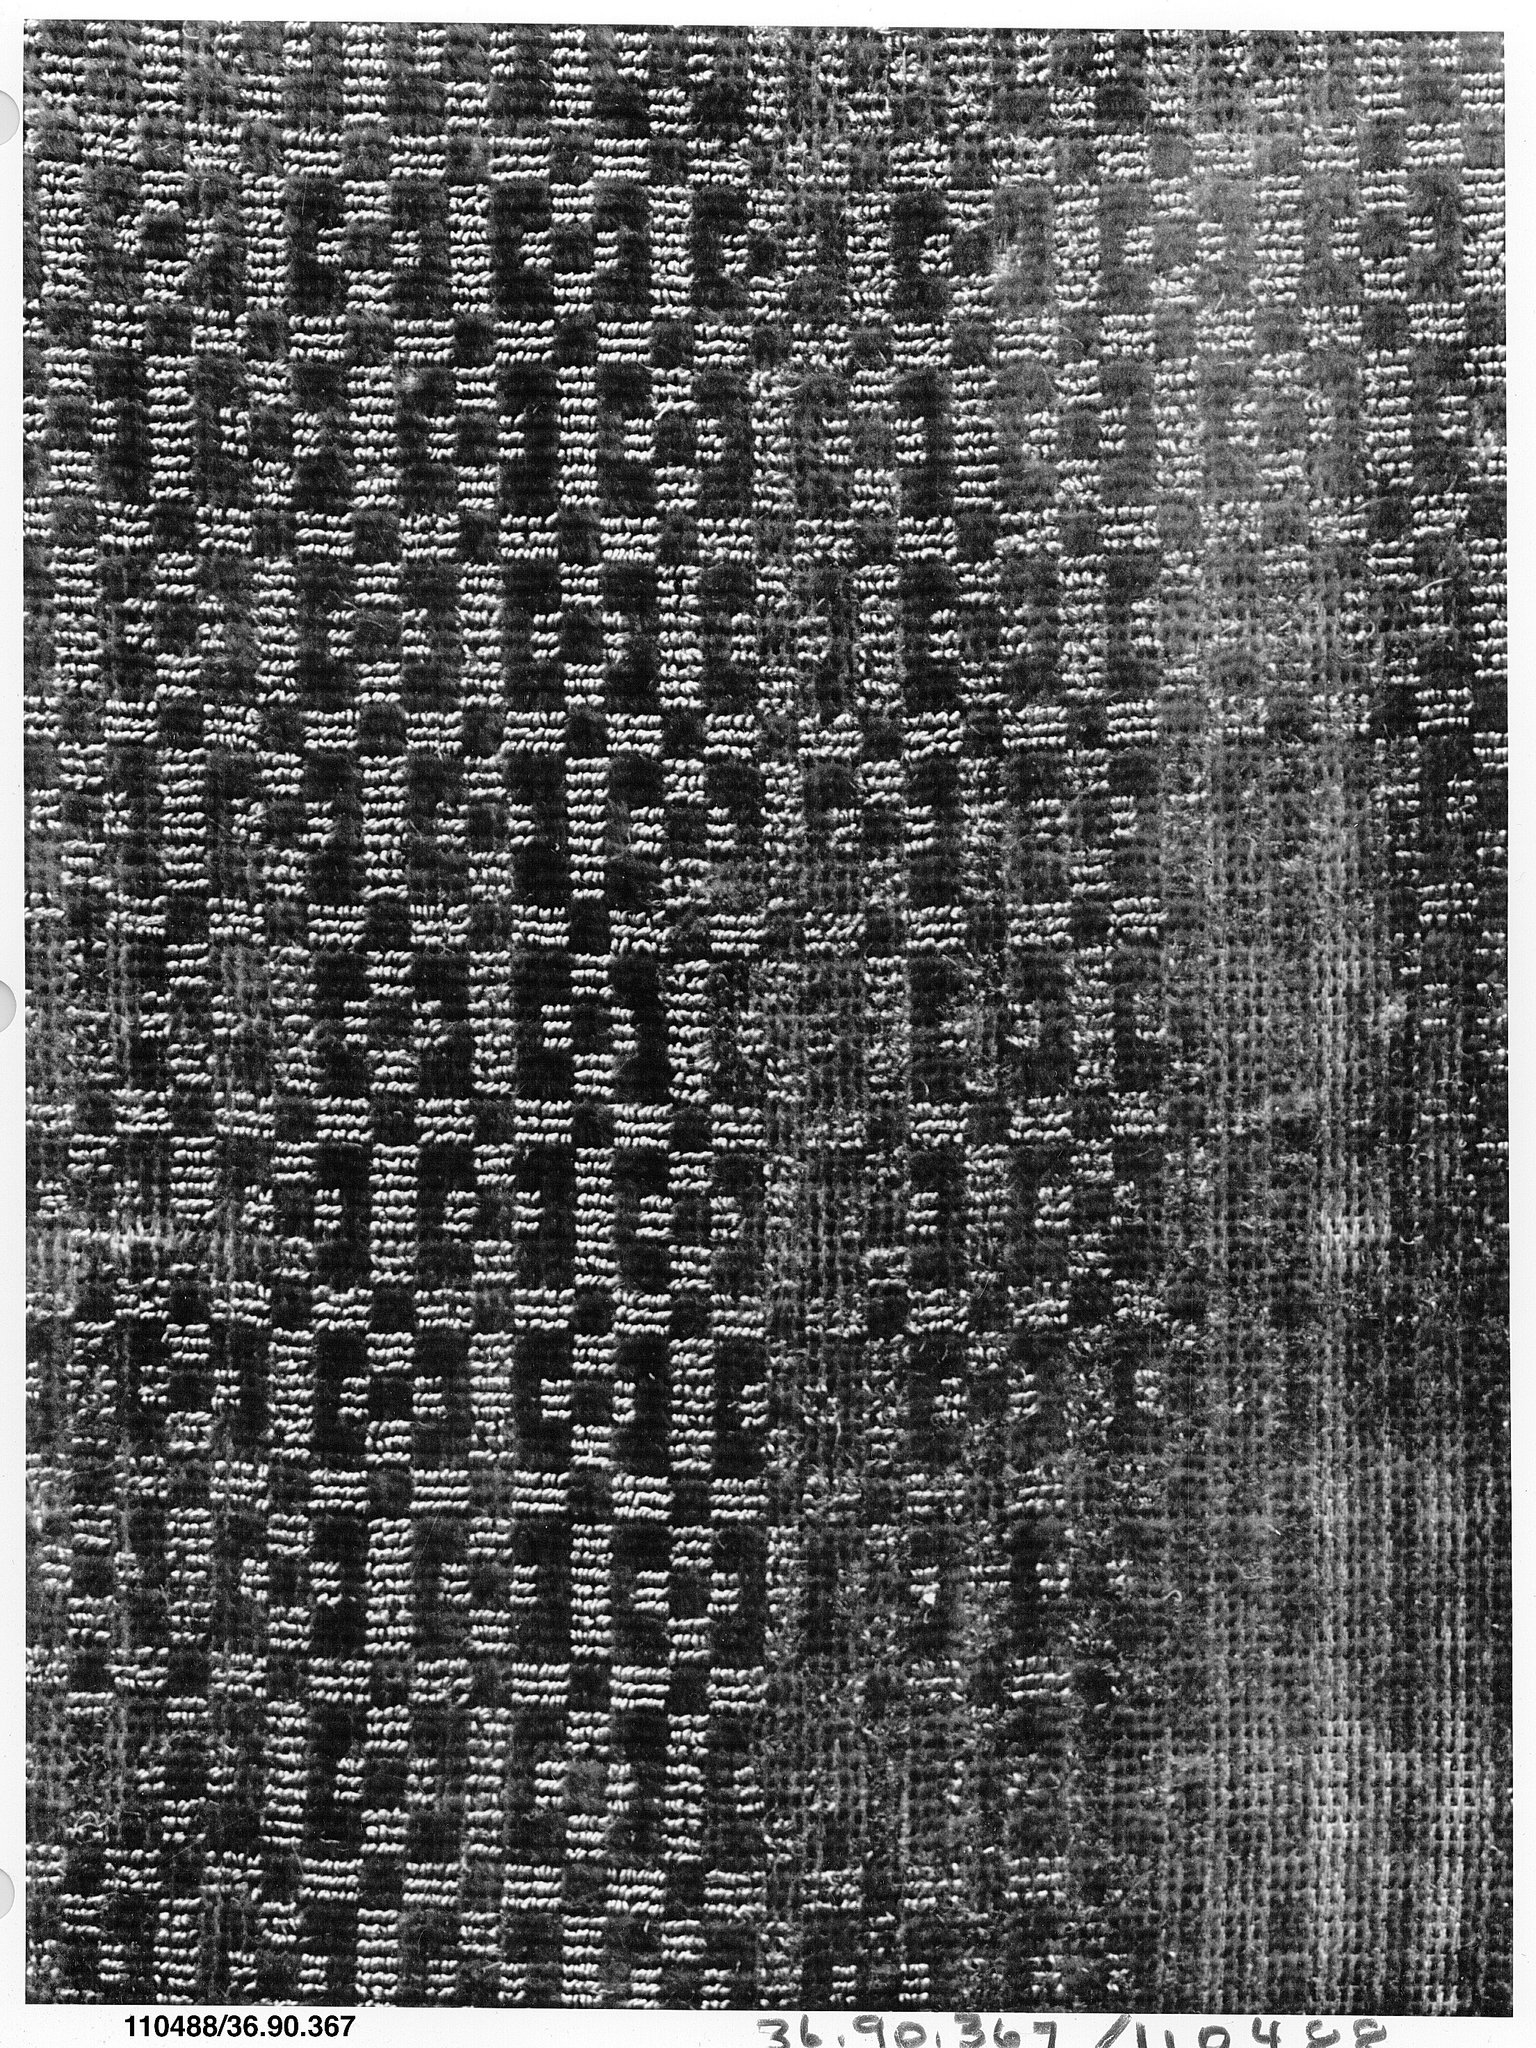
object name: piece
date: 1501-1700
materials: silk